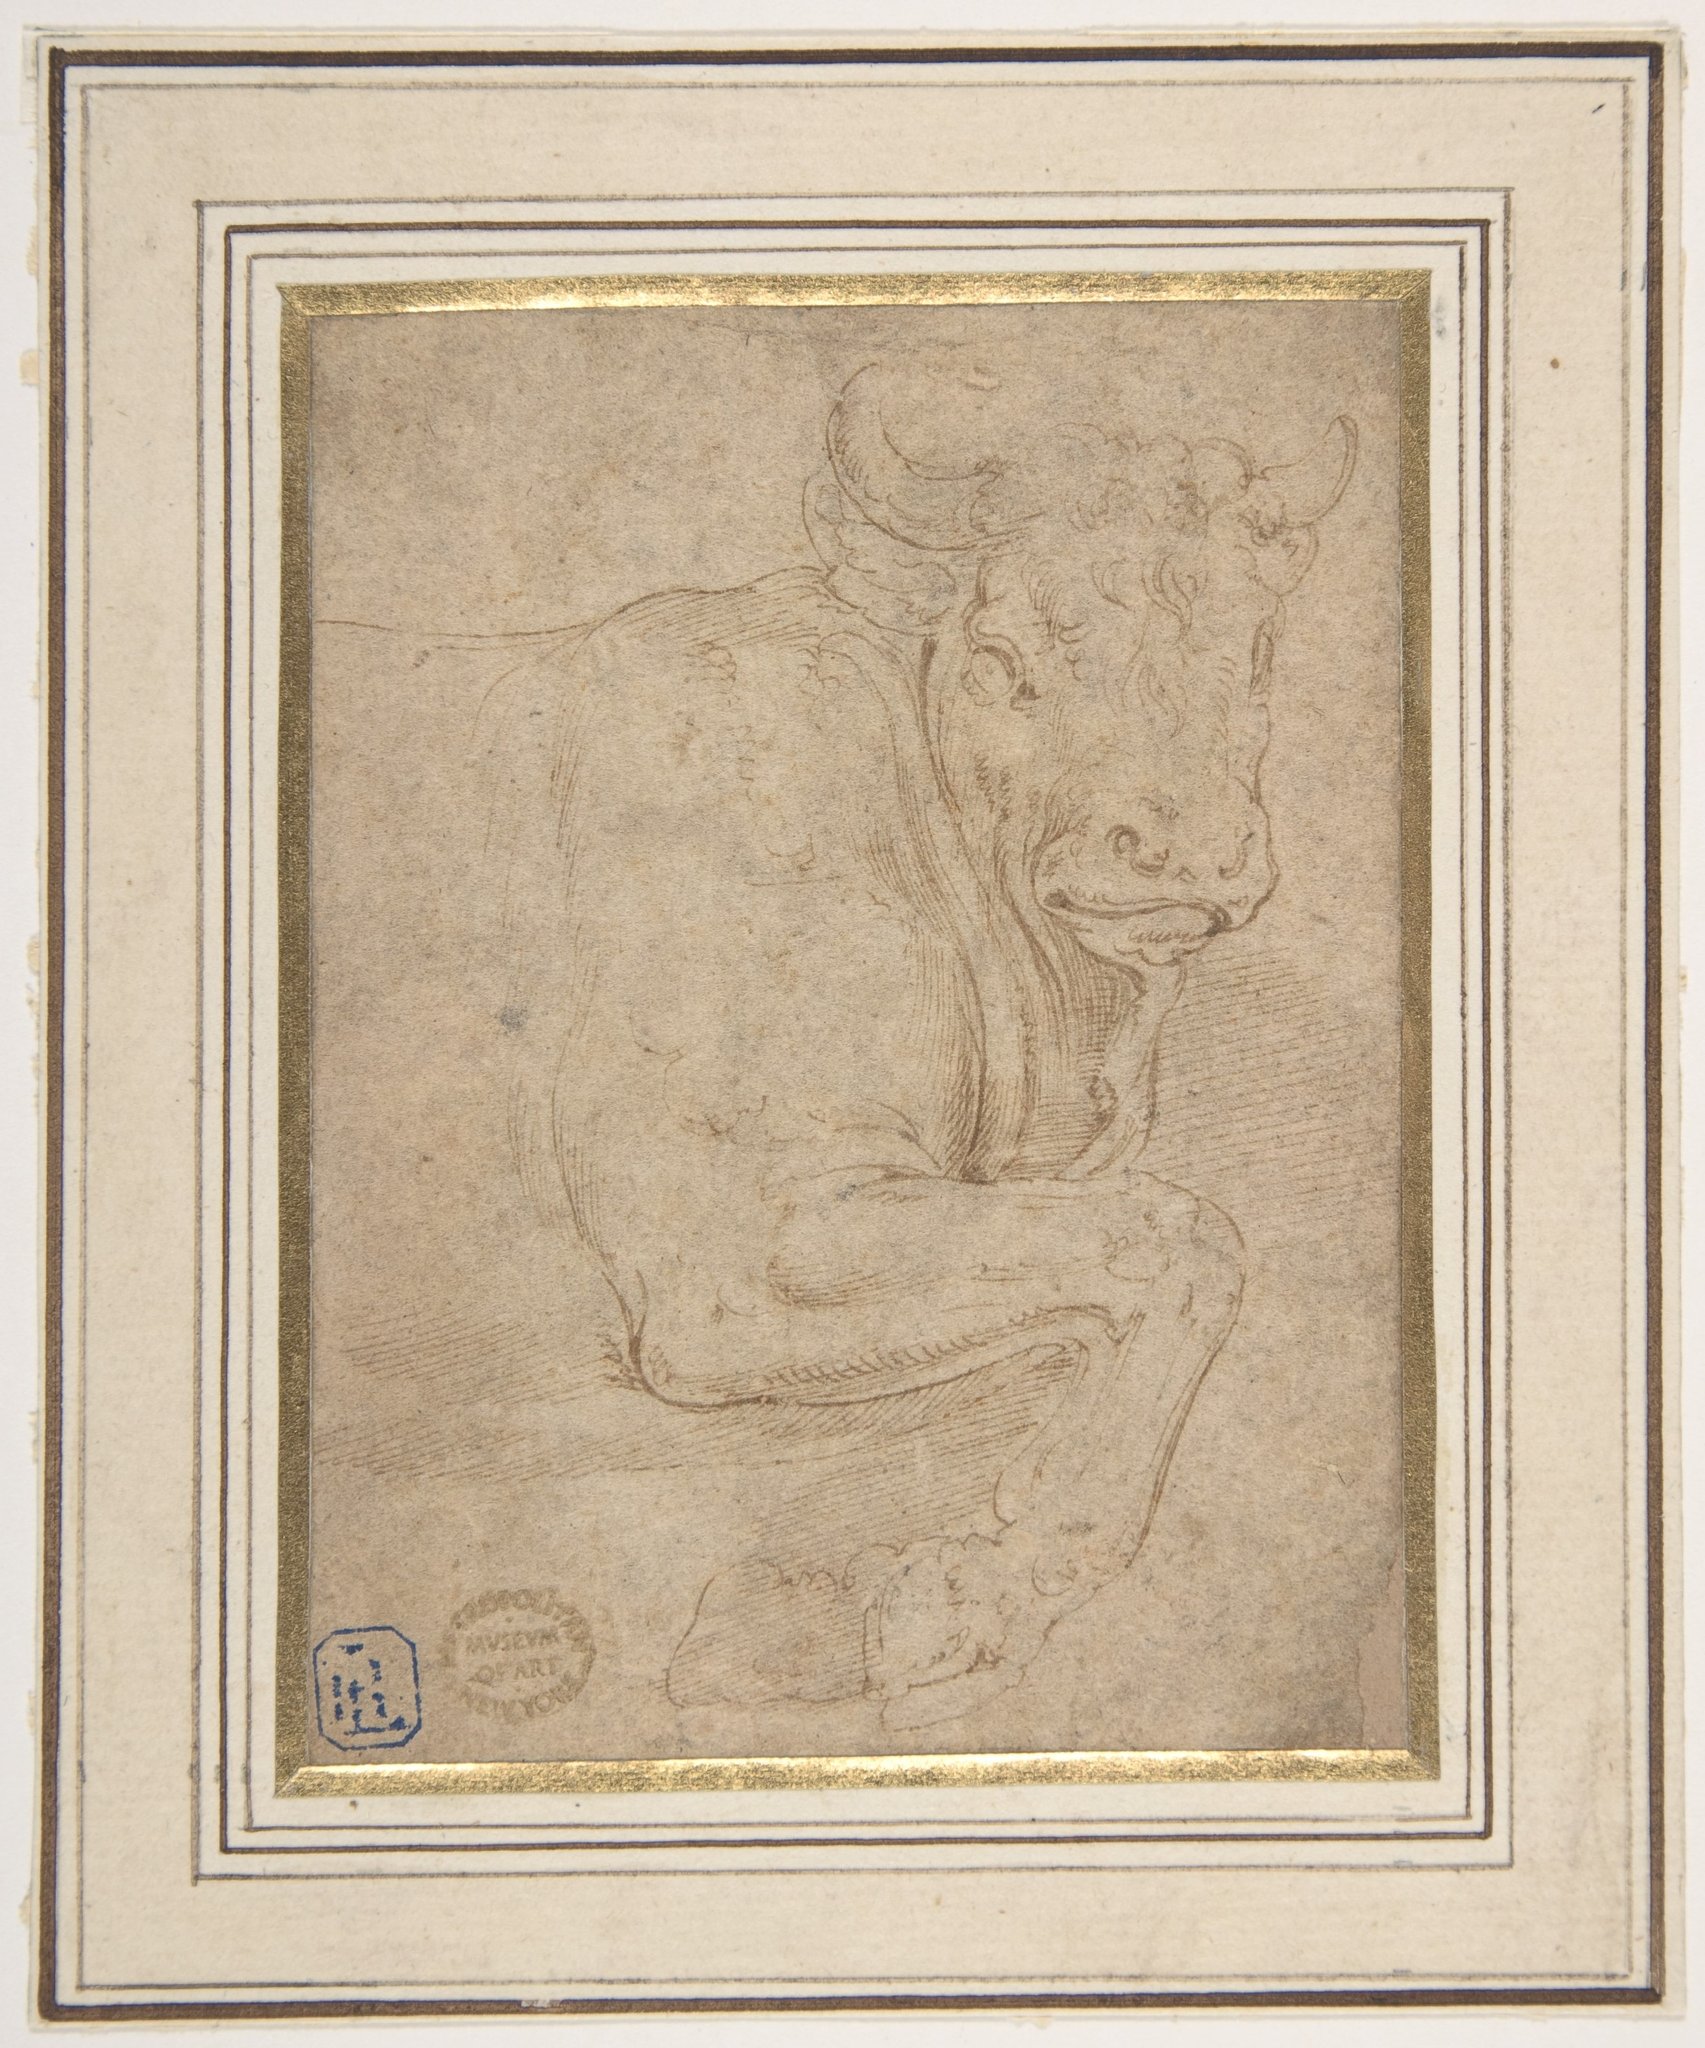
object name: drawing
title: Head and Front Quarters of a Bull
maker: battista franco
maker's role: artist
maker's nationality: italian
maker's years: 1510-1561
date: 1510-1561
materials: ink, paper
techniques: pen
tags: bulls